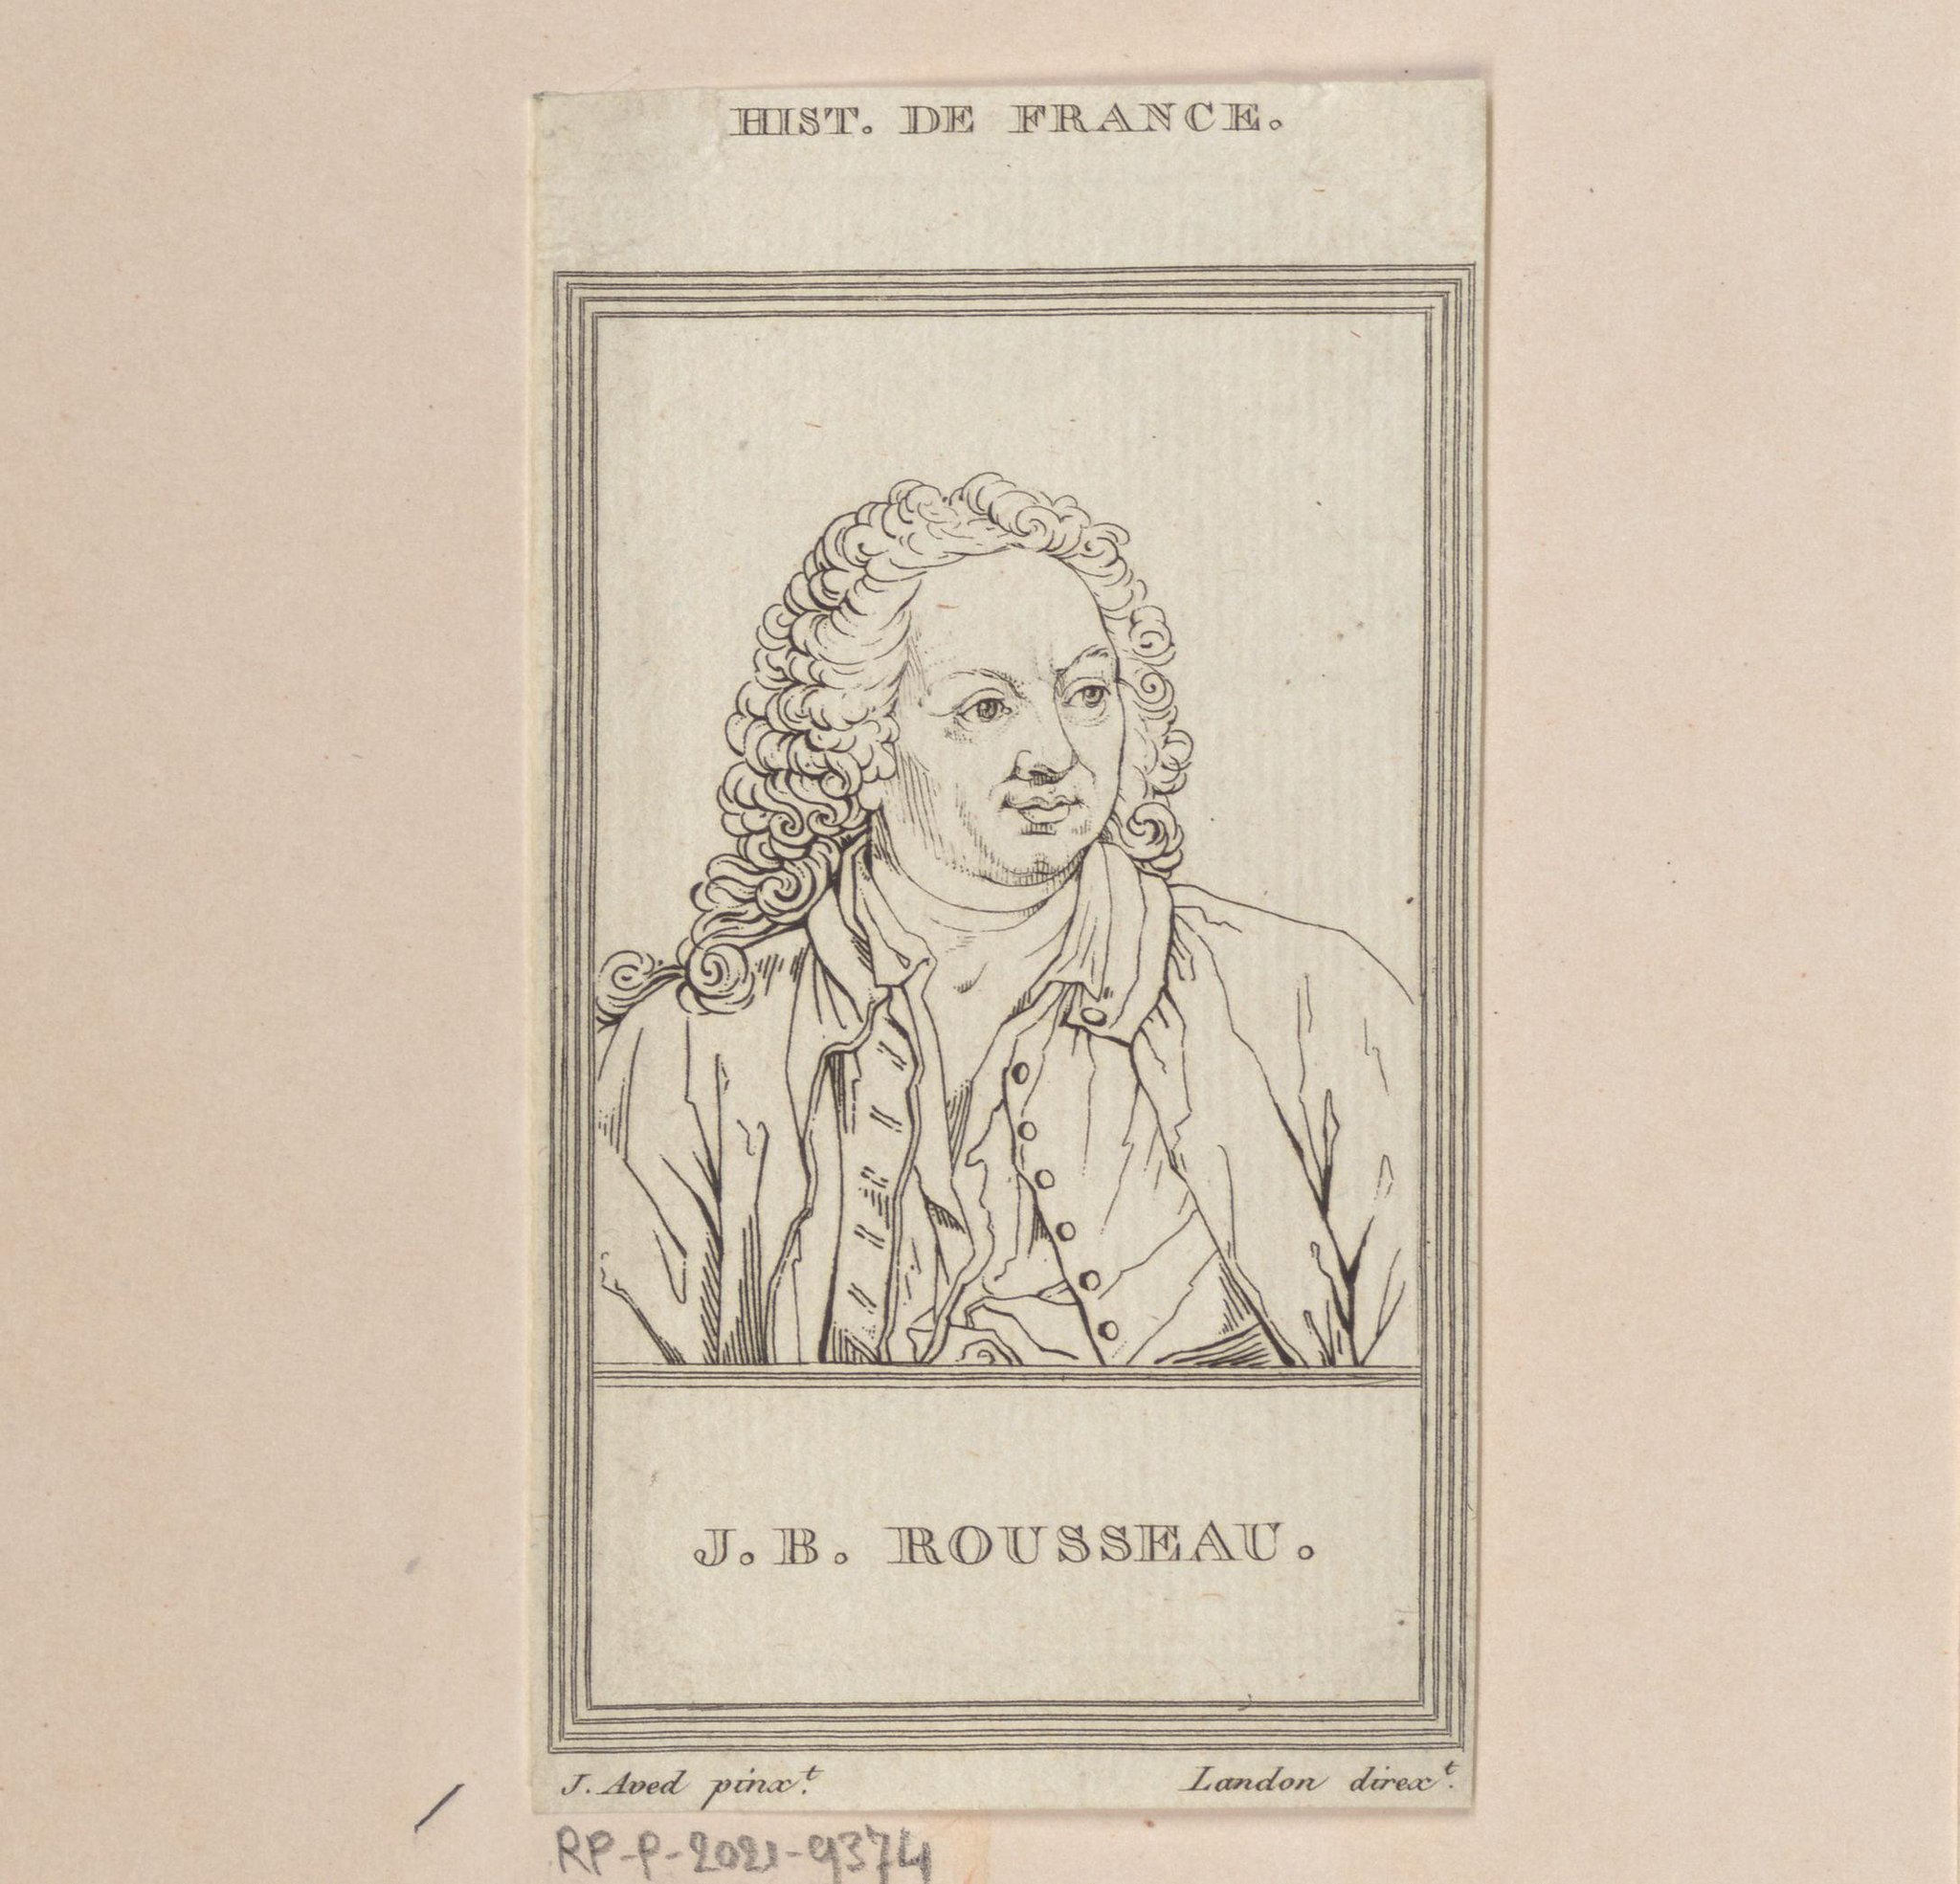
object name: print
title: Portret van Jean Baptiste Rousseau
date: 1807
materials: paper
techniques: etching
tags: paris, brussels, jean baptiste rousseau (1669-1741), historical persons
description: Prent waarschijnlijk uit: Galerie historique des hommes les plus célèbres (...). Parijs: Charles Paul Landon, 1807, dl. 10.